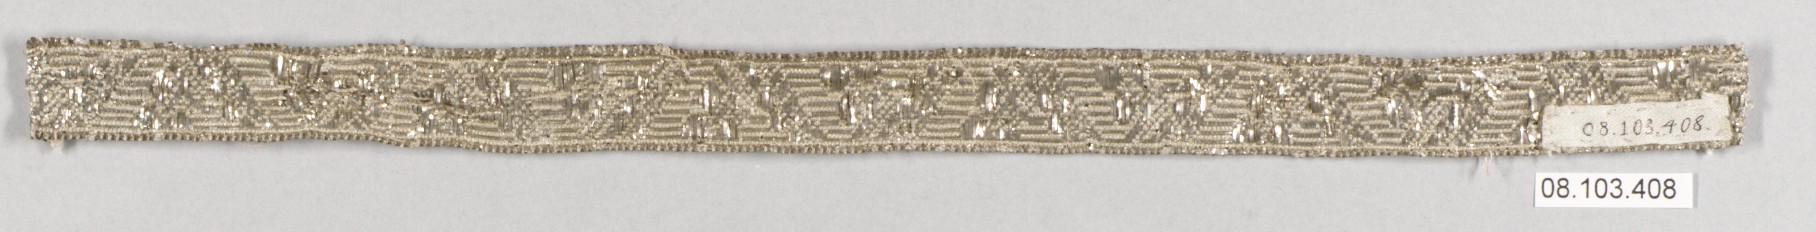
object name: galloon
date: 1701-1800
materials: metal thread